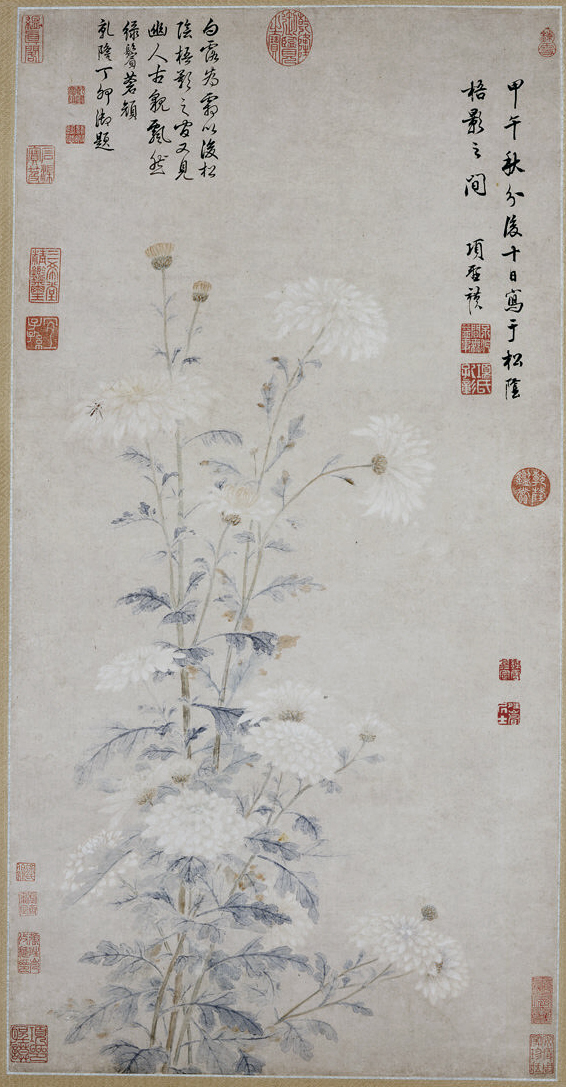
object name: hanging scroll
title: White Chrysanthemums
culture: chinese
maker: xiang shengmo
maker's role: artist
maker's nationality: chinese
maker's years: 1597-1658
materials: paper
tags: flowers